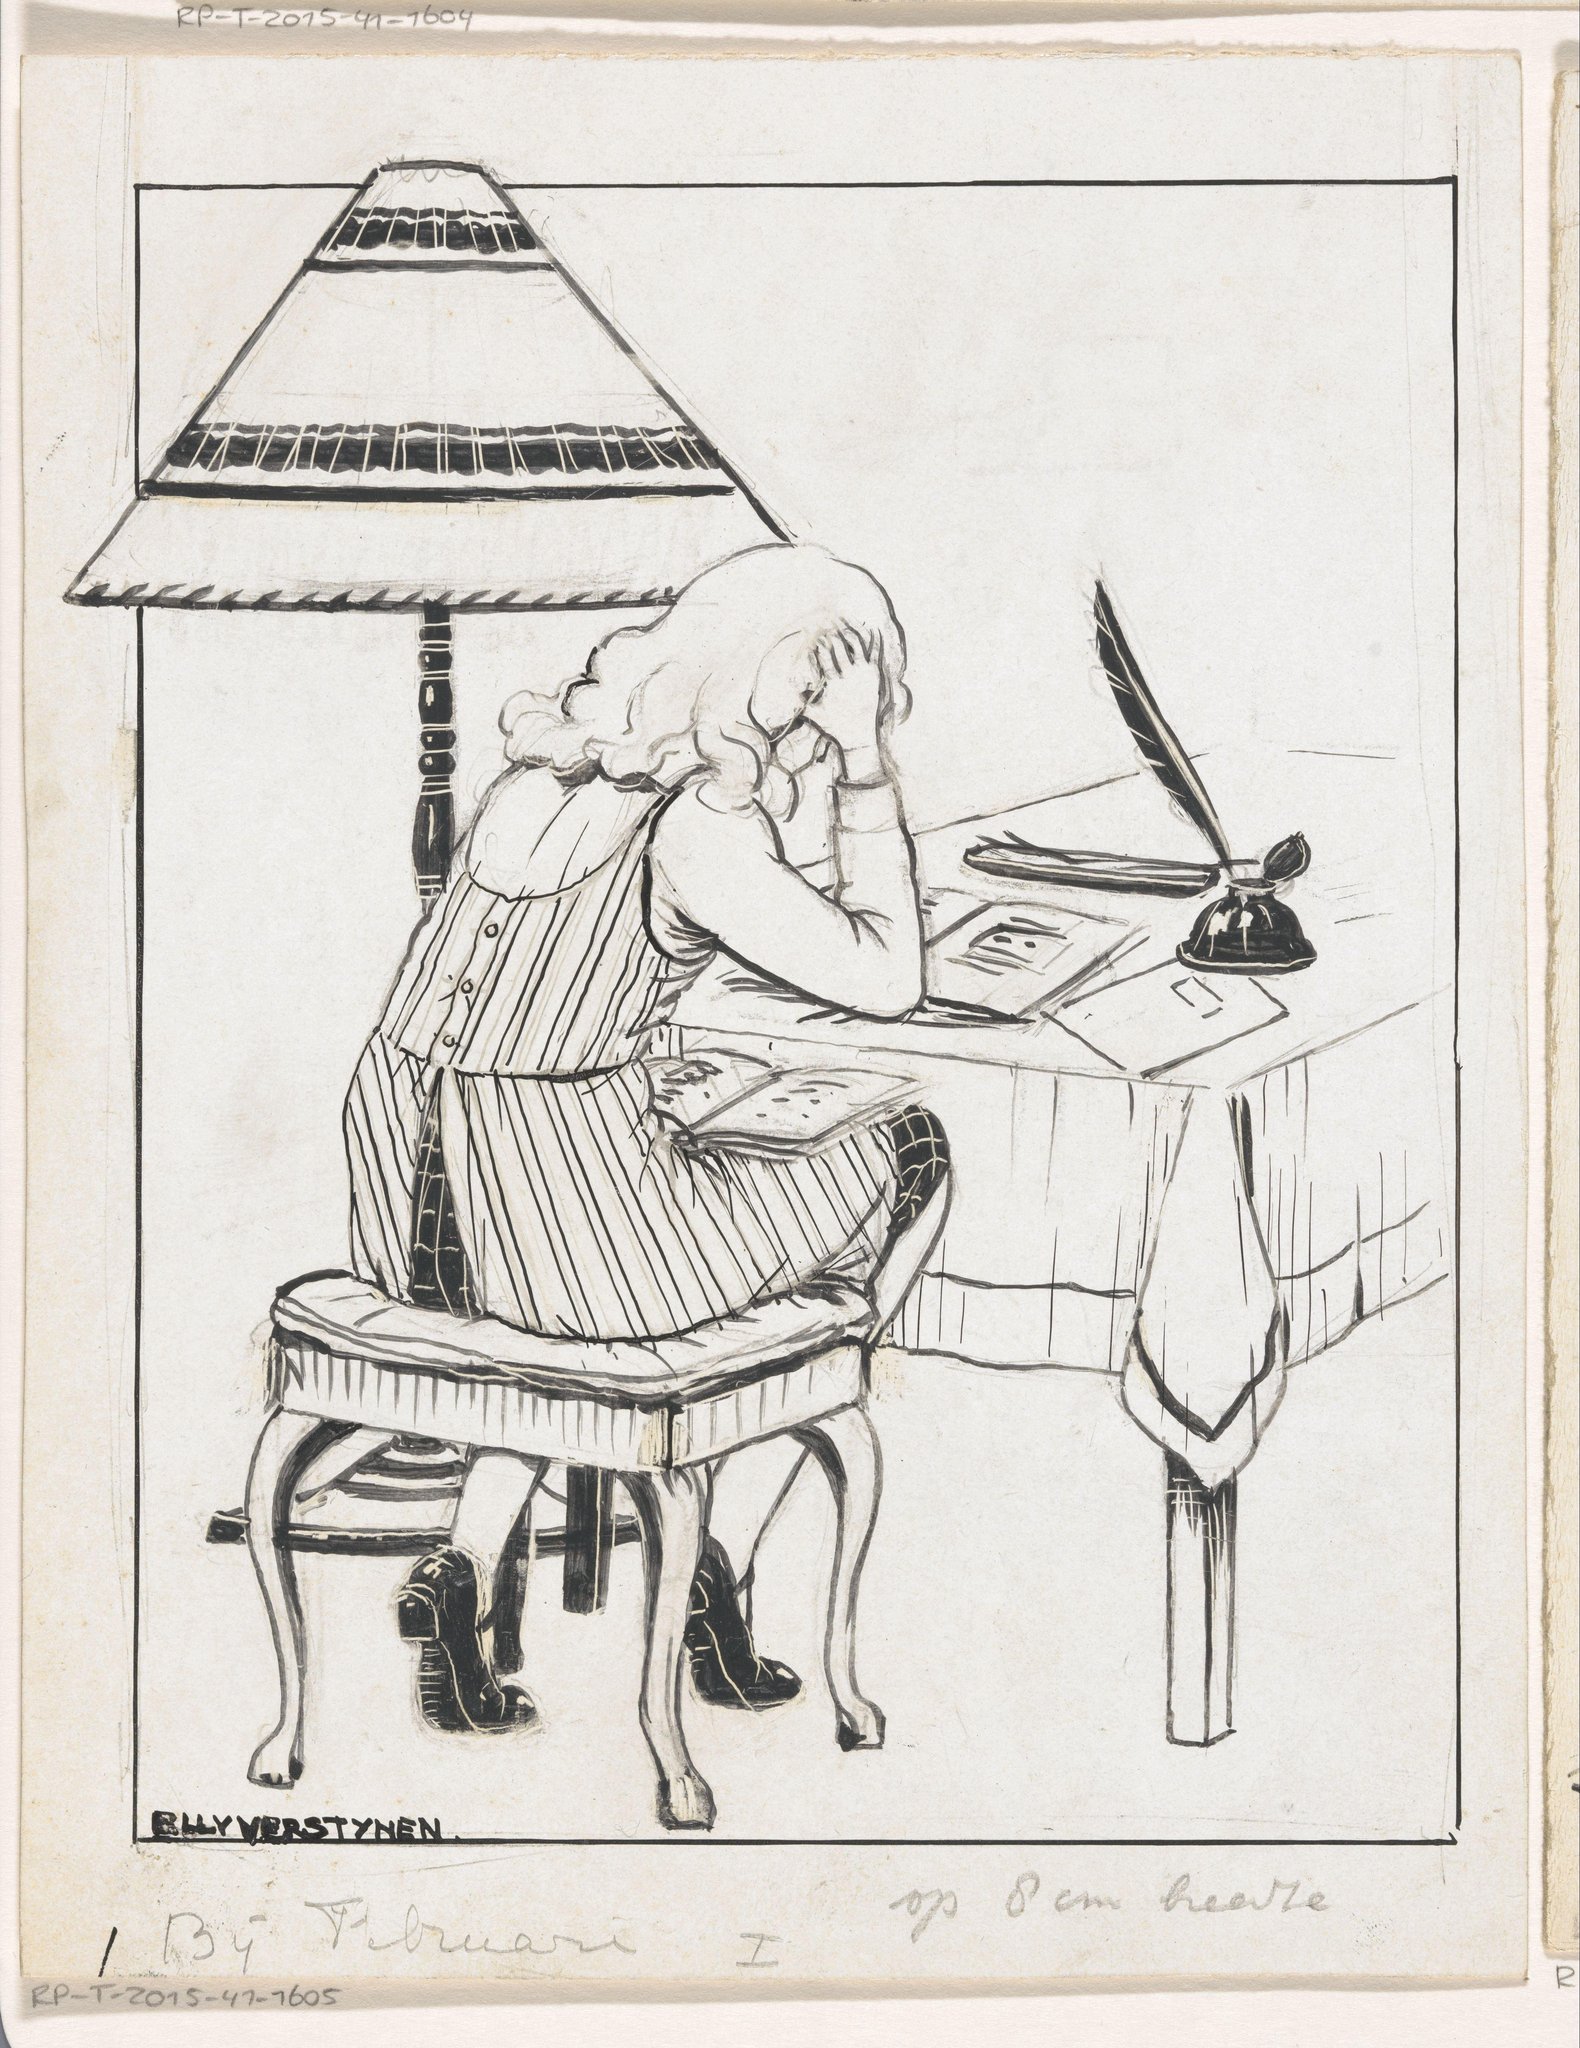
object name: boekillustratie ontwerp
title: Lezend meisje aan een tafel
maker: elly verstijnen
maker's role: draughtsman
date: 1900-1930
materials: ink, paper, pencil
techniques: brush, pen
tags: reading, ink-well, table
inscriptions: signature: ‘ELLY VERSTYNEN.’, annotation: ‘Bij Februari I’, collector's mark: Lugt 2228, :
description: Een meisje zit met een boek op schoot te lezen. Ze steunt met haar ellebogen op tafel. Op de tafel staat een inktpot met ganzenveer en liggen schriften.